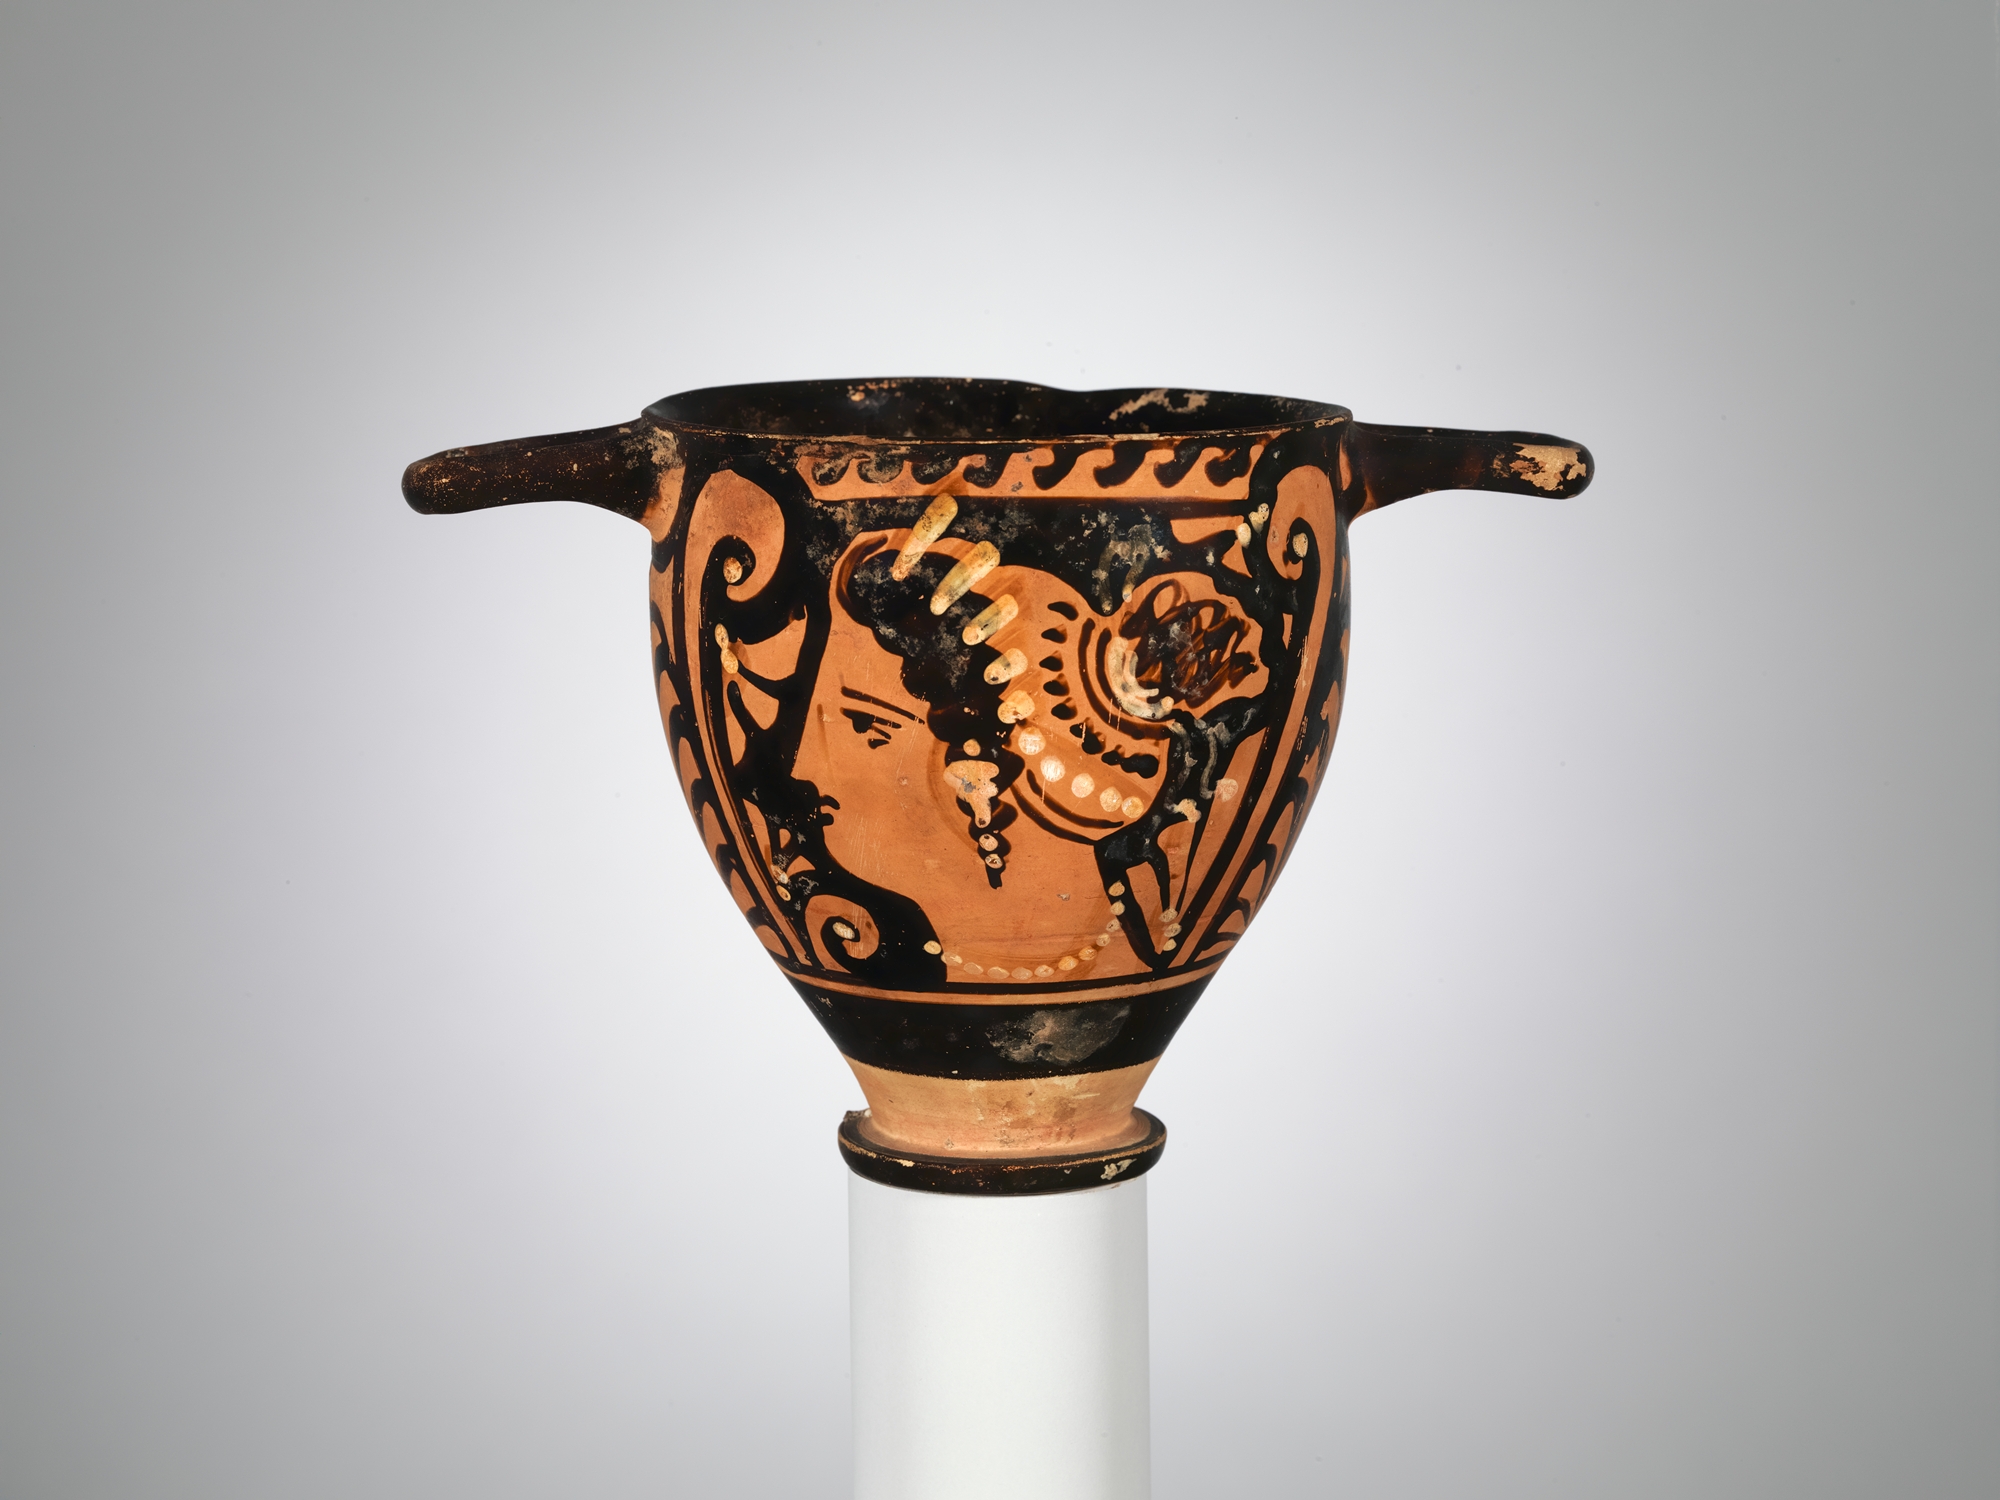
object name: skyphos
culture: greek, south italian, apulian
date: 325-300 BCE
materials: terracotta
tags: heads,women